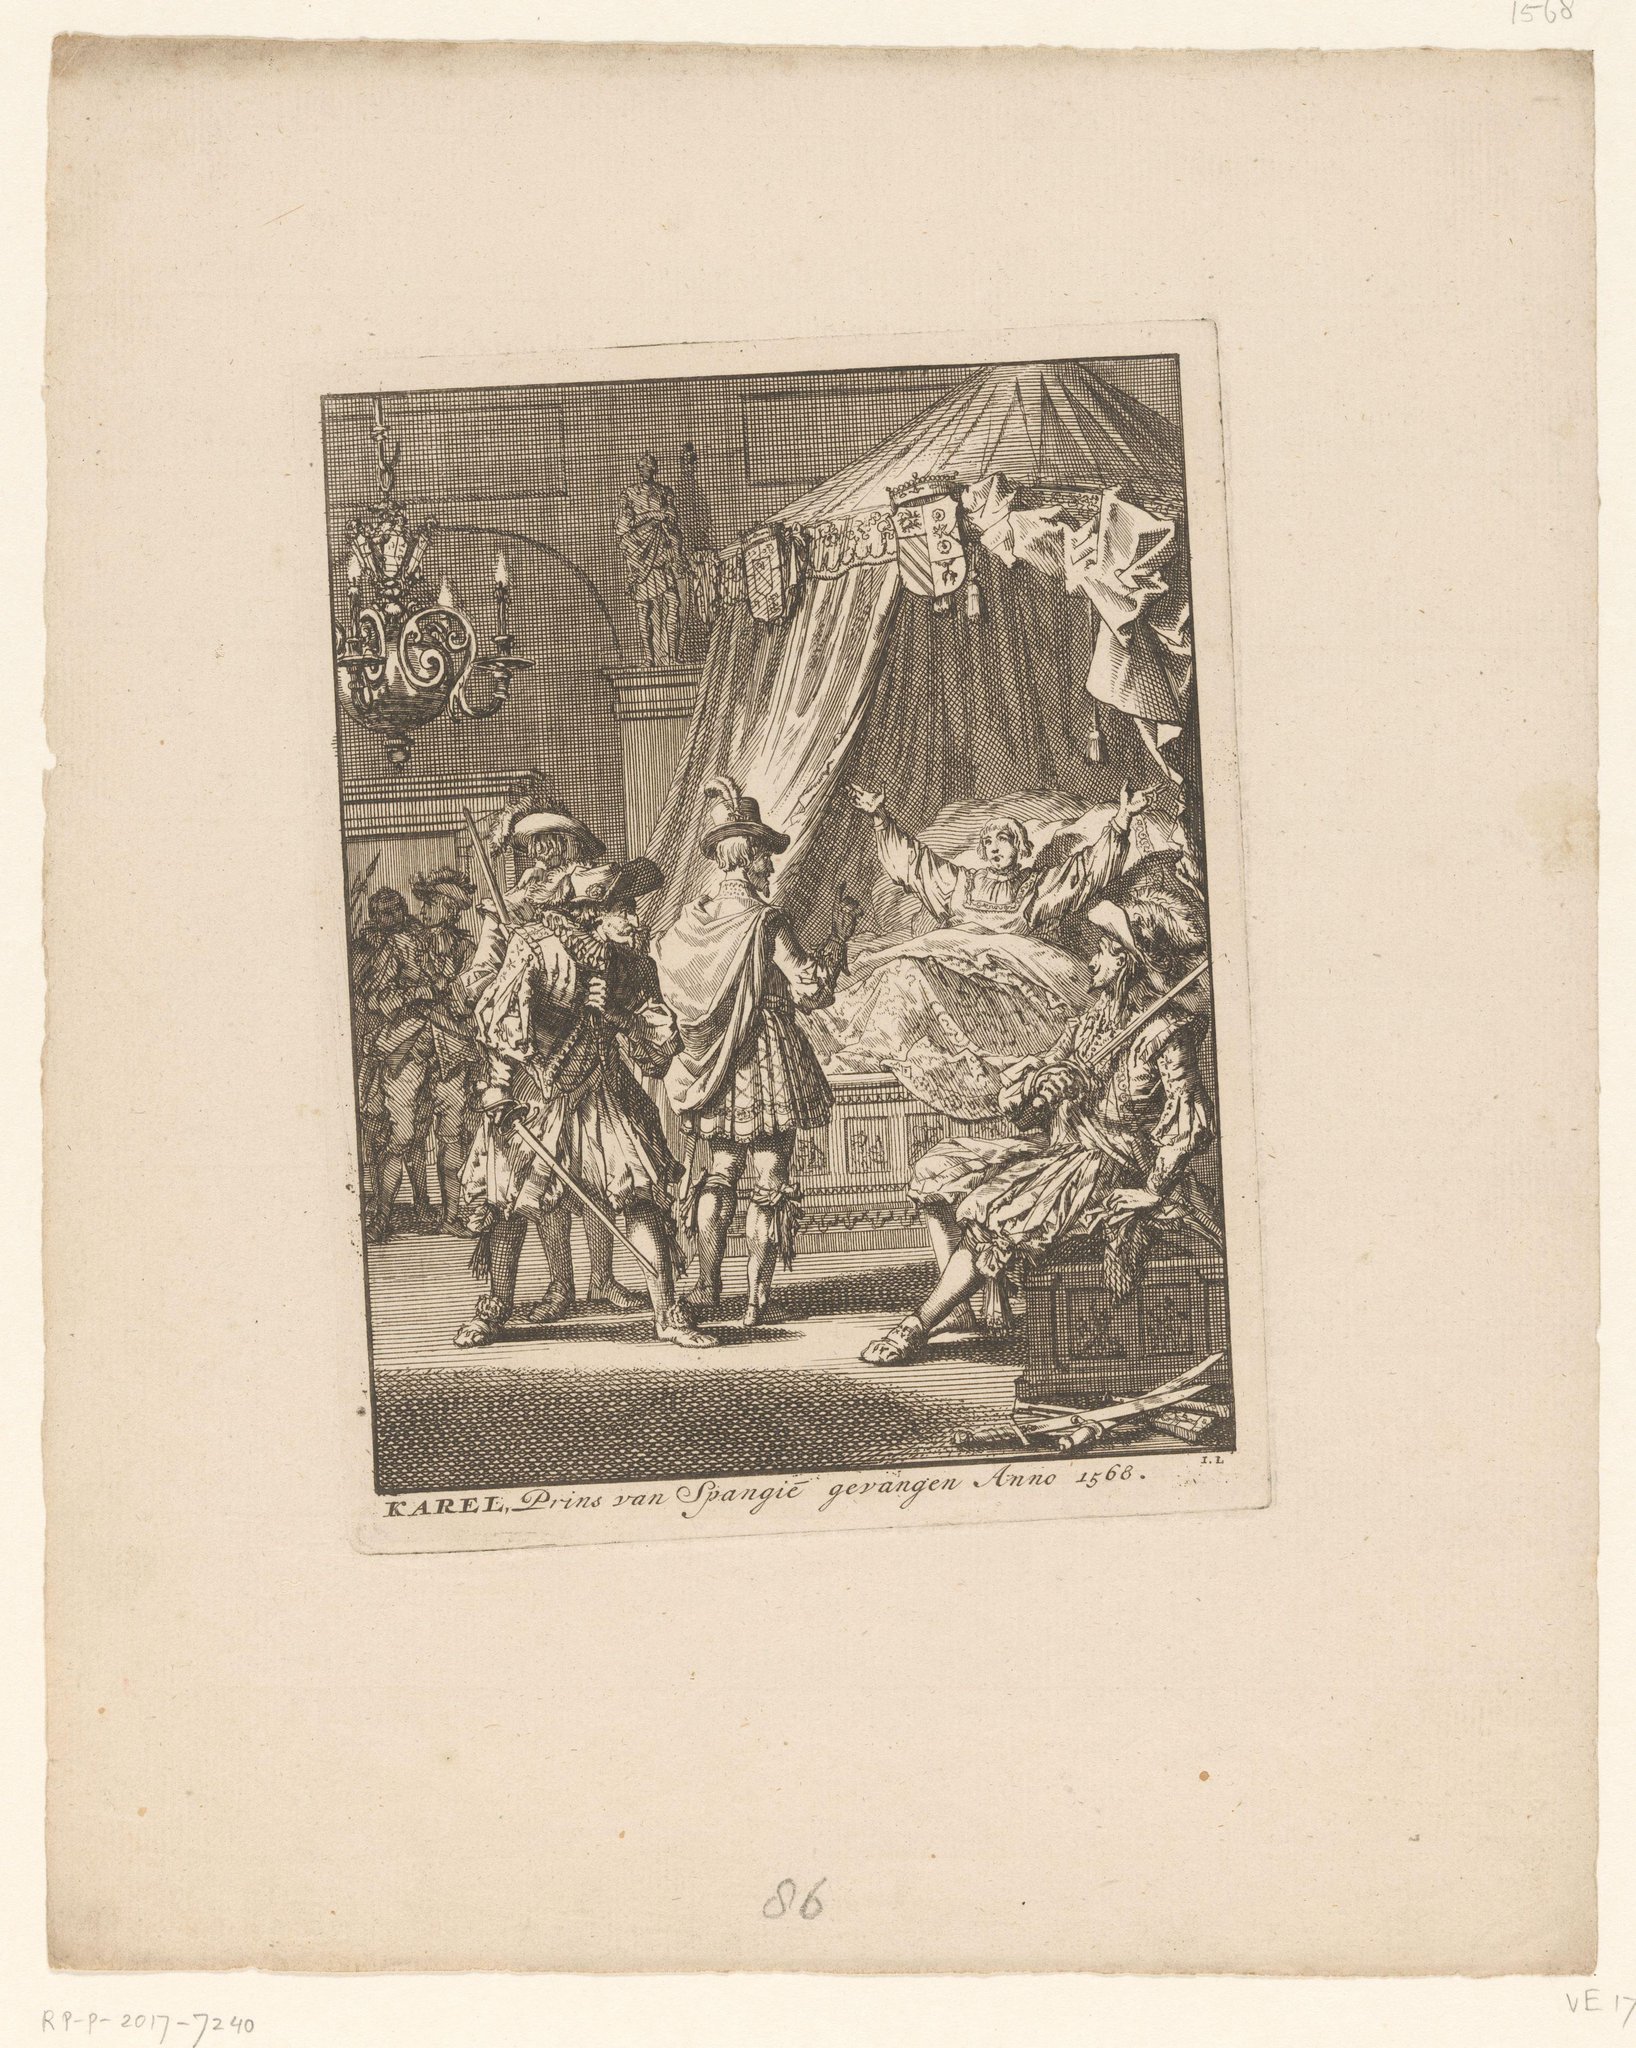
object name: print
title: Schijnbegrafenis van keizer Karel V, 1558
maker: jan luyken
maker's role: draughtsman, print maker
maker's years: 1649-1712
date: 1699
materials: paper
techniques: etching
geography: netherlands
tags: ghent, charles v (holy roman emperor and king of spain), battle, fighting in general (+ land forces)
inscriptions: collector's mark: Lugt 2228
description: Gebruikt als illustratie in: Leti, Gregorio. Het Leven van Filips de II, Koning van Spanien. Vertaald door N.J. Wieringa. Den Haag: Engelbreght Boucquet, 1699, dl.1, f. 270.